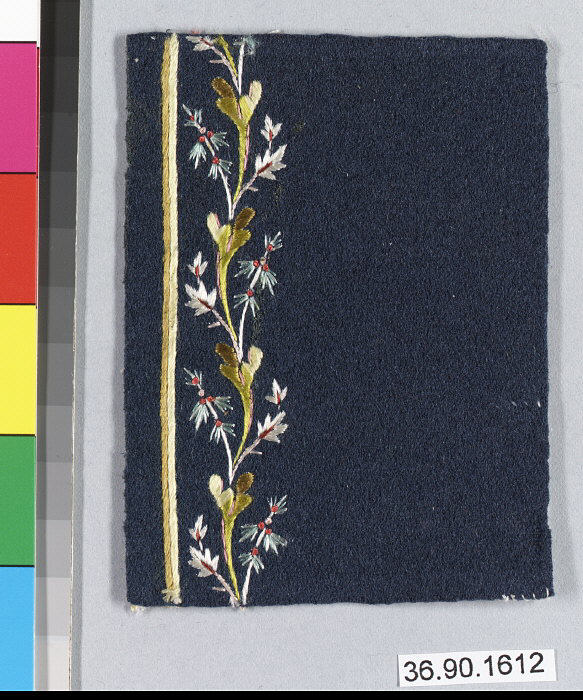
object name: sample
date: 1801-1833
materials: felt, silk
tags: flowers